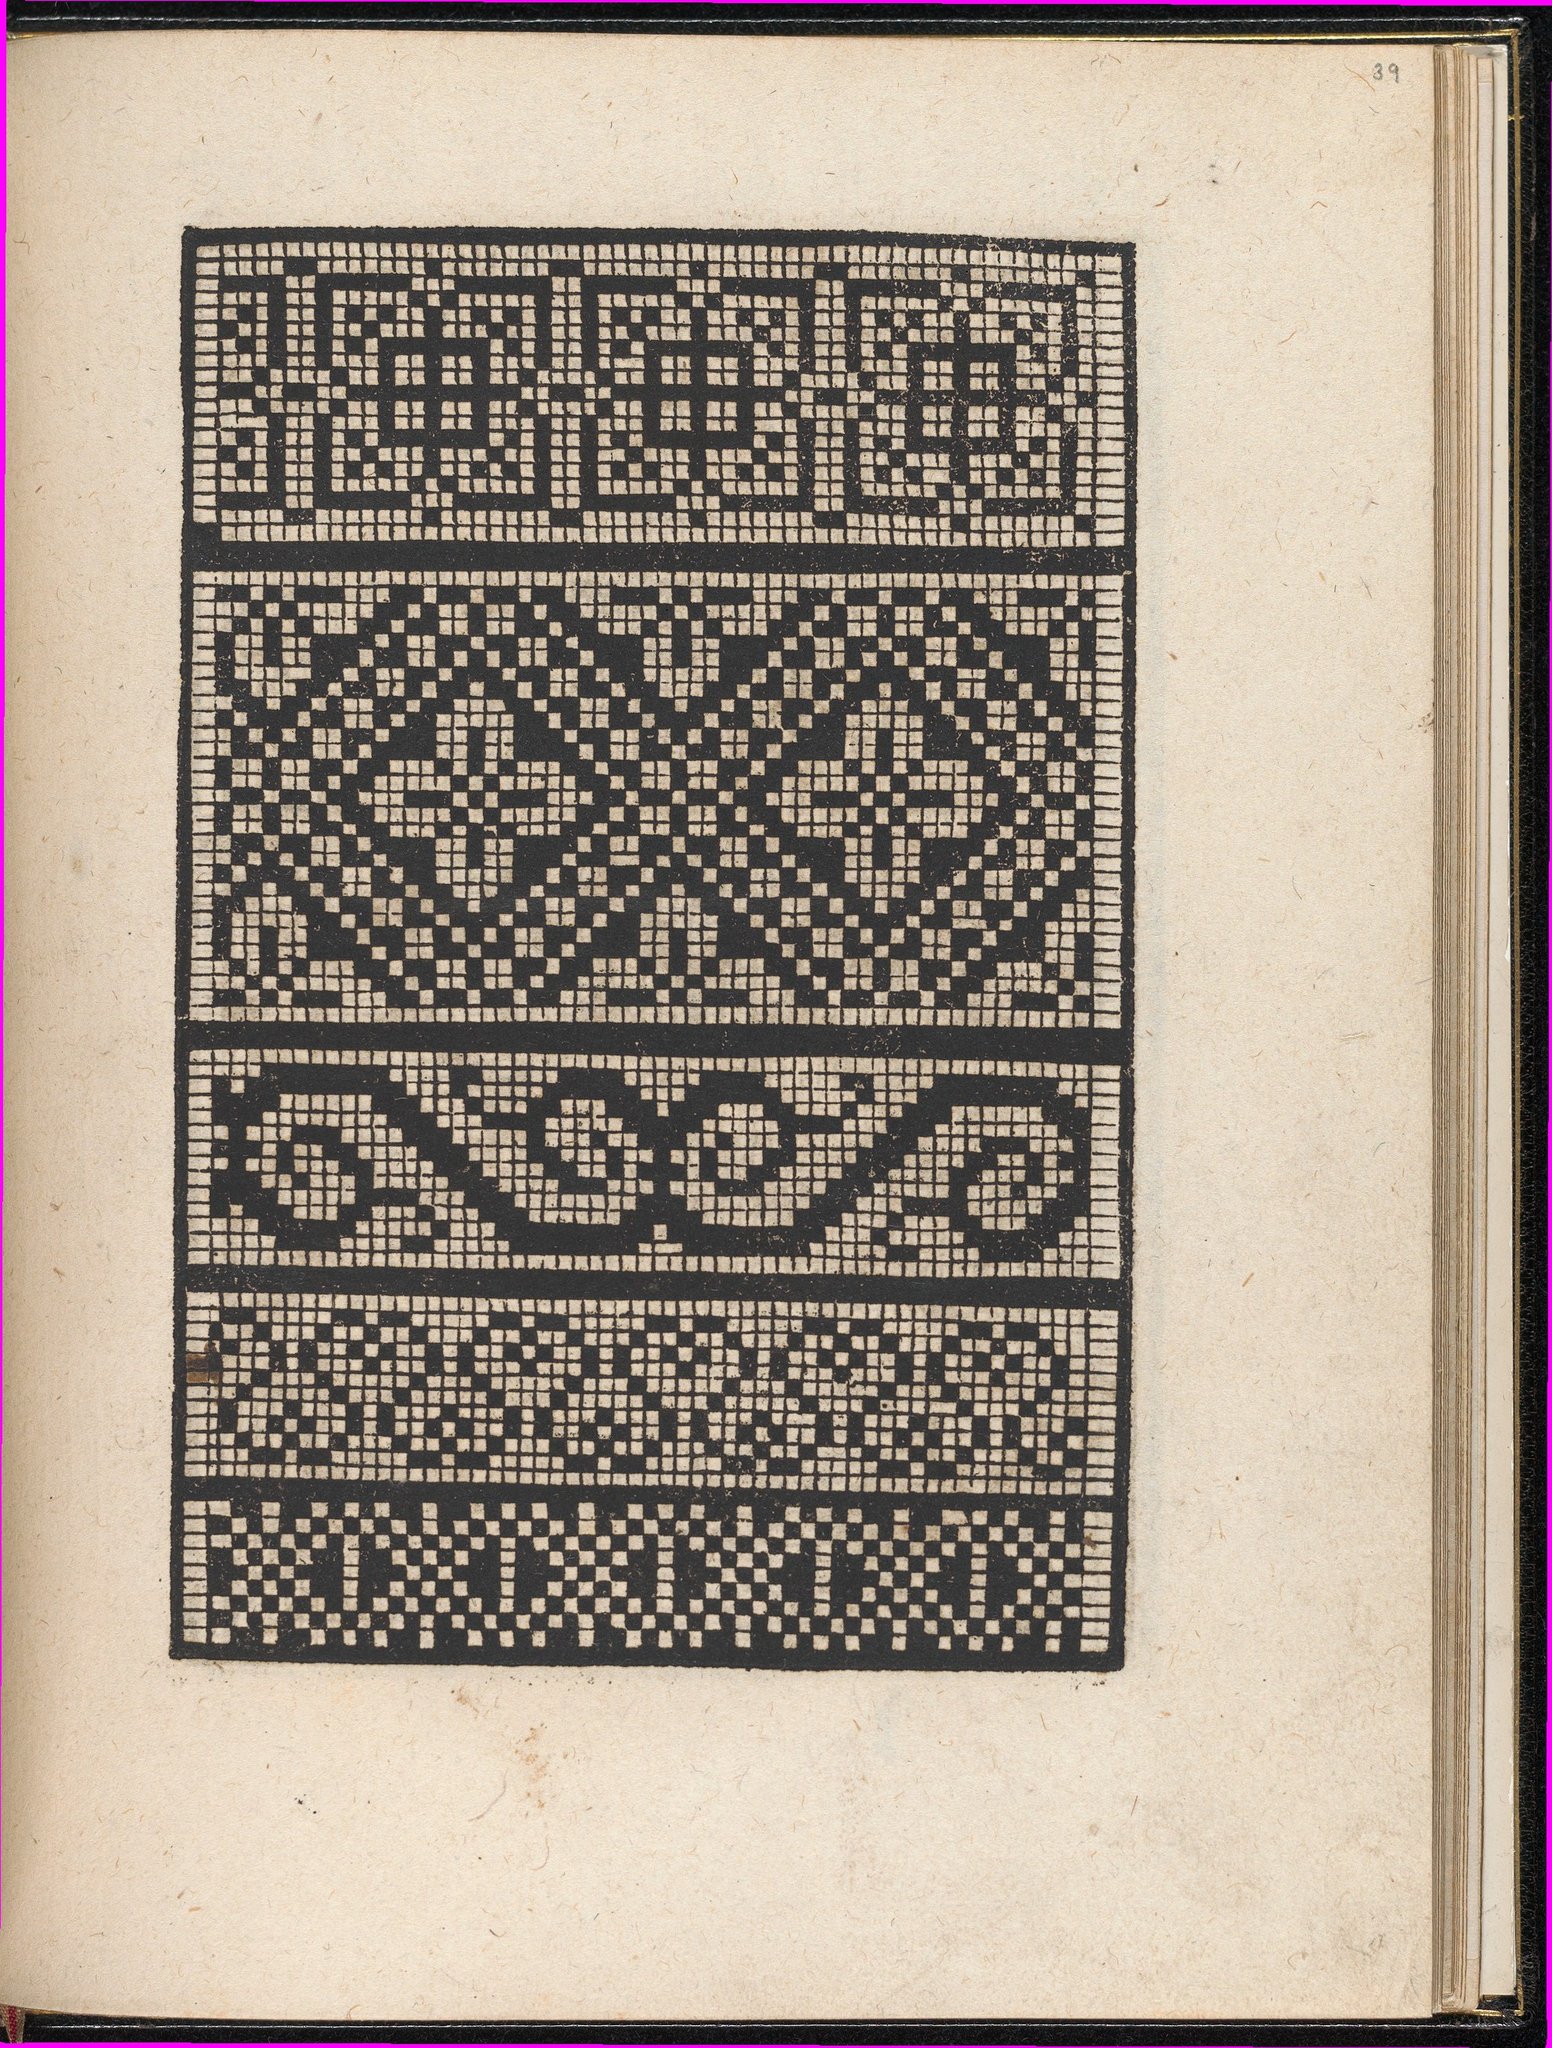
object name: book print ornament architecture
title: Page from Ein new kunstlich Modelbuch...(Page 39v)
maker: peter quentel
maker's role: publisher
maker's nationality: german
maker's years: 1500-1550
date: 1544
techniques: woodcut